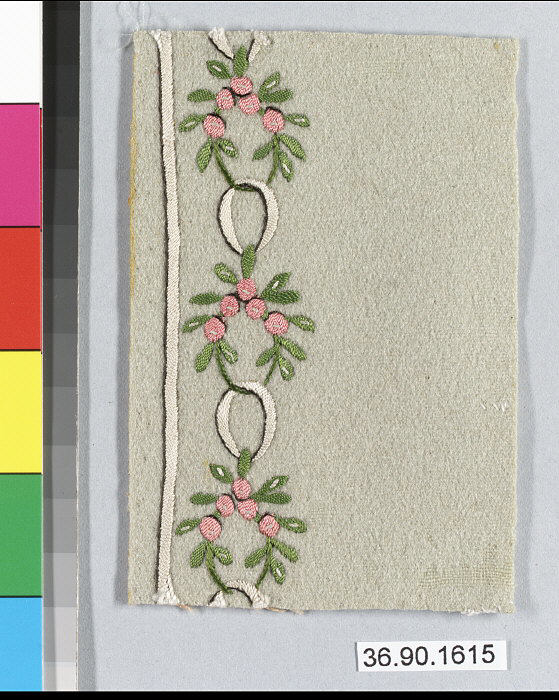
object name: sample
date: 1801-1833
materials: felt, silk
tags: flowers